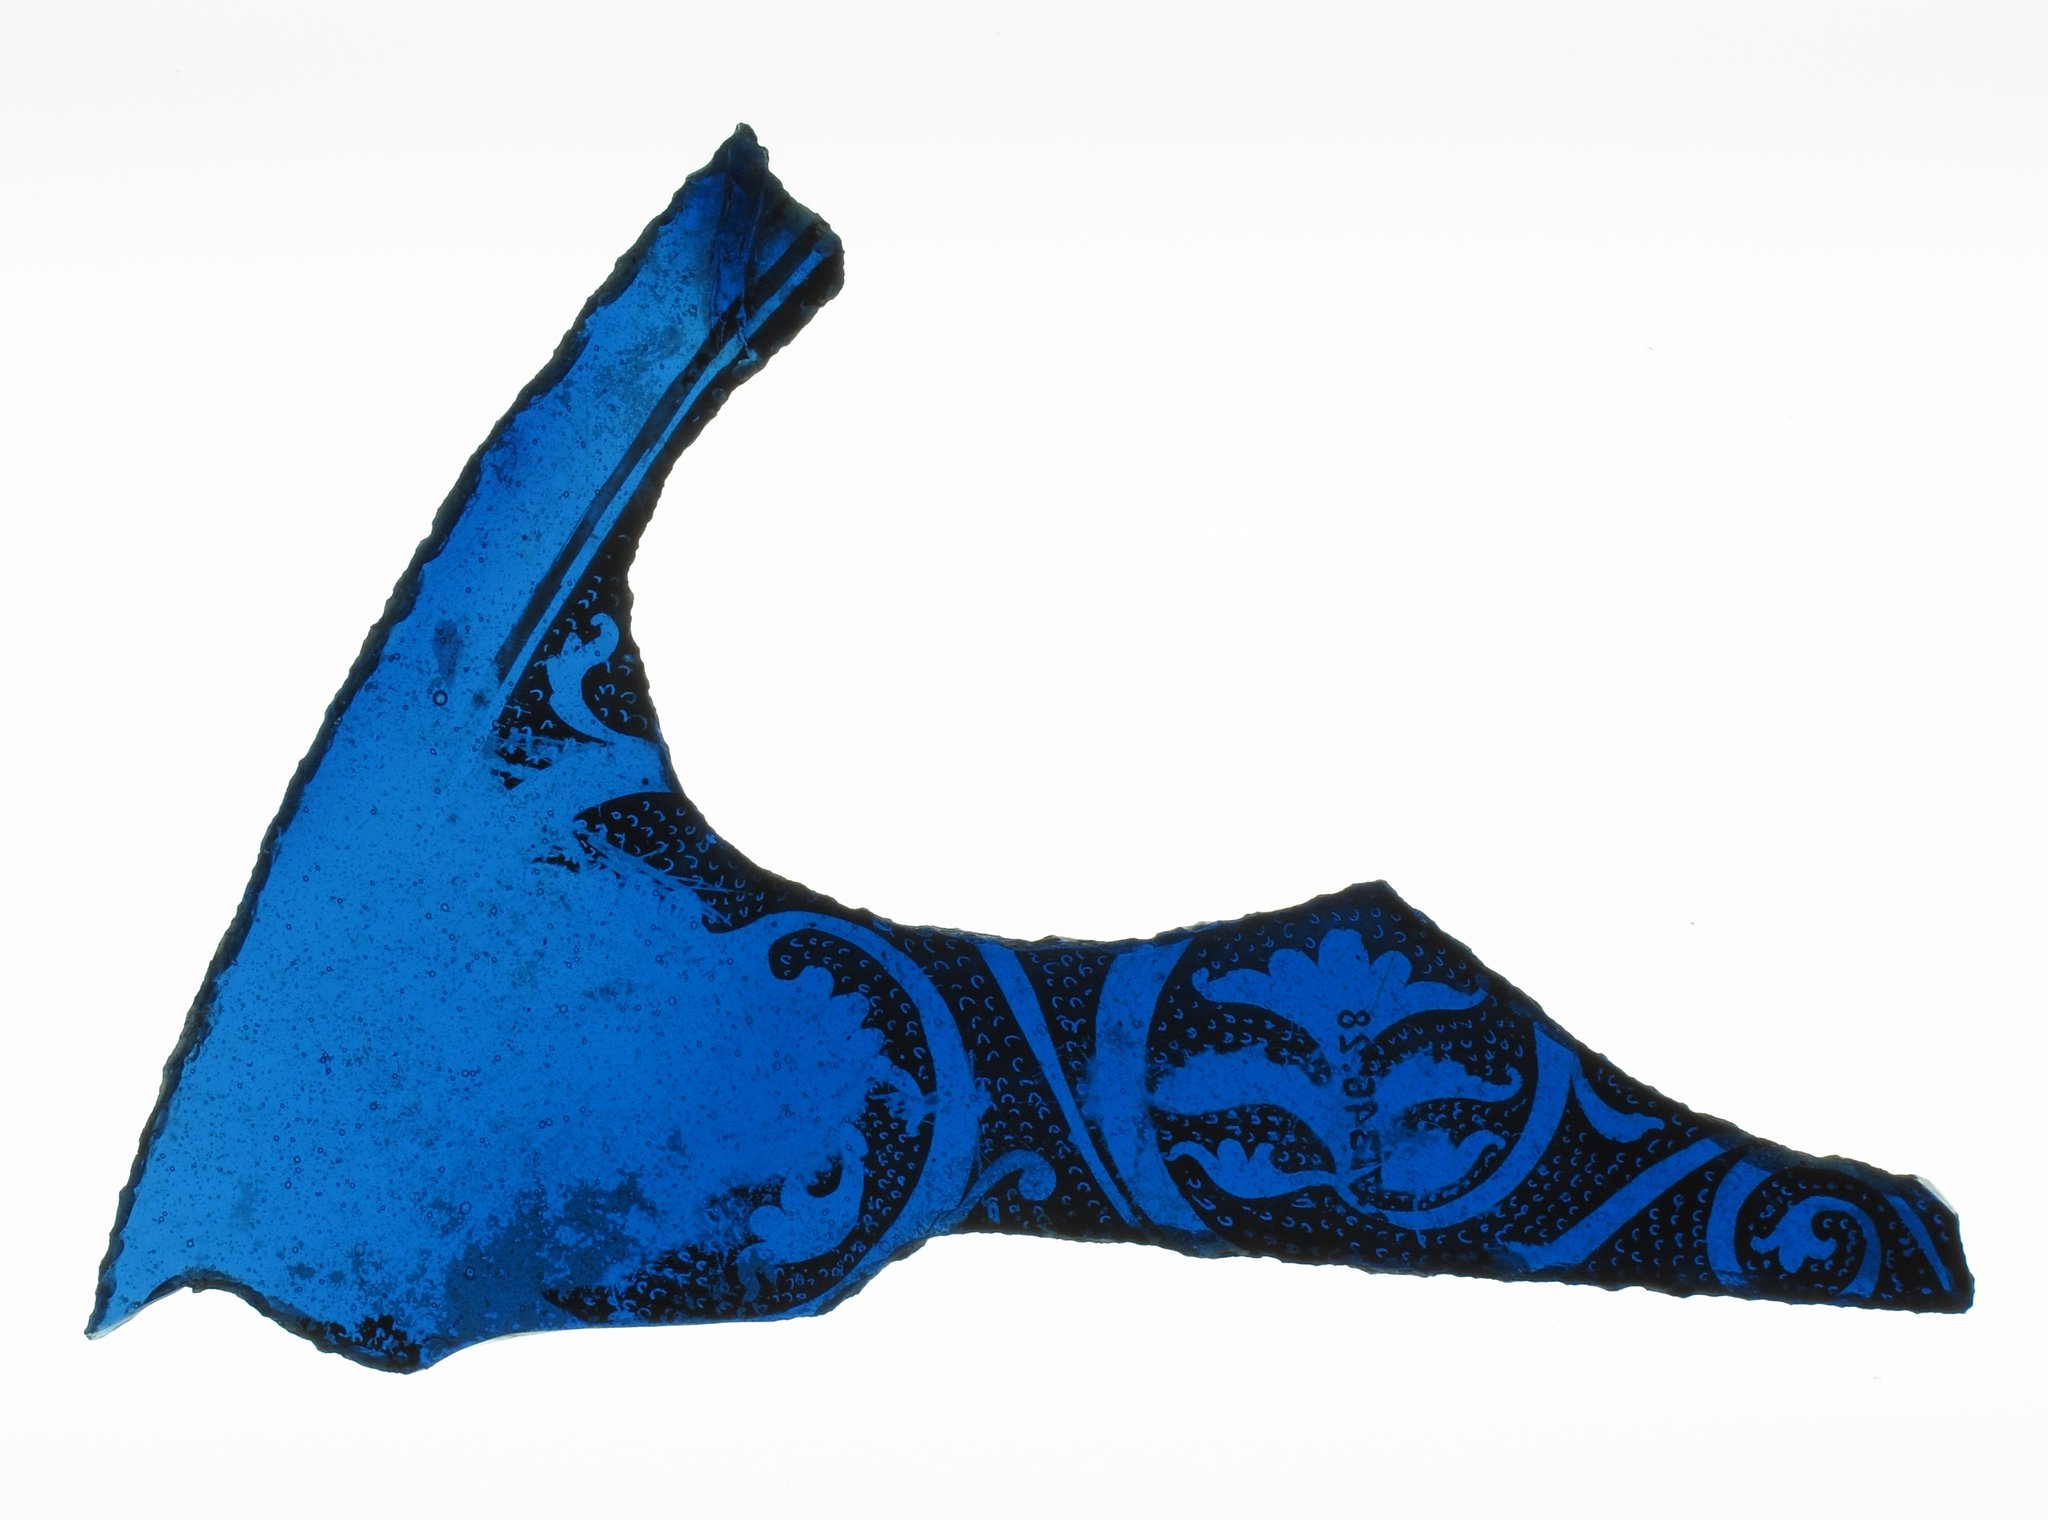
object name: fragment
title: Glass Fragment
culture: french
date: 1101-1400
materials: glass, metal, paint